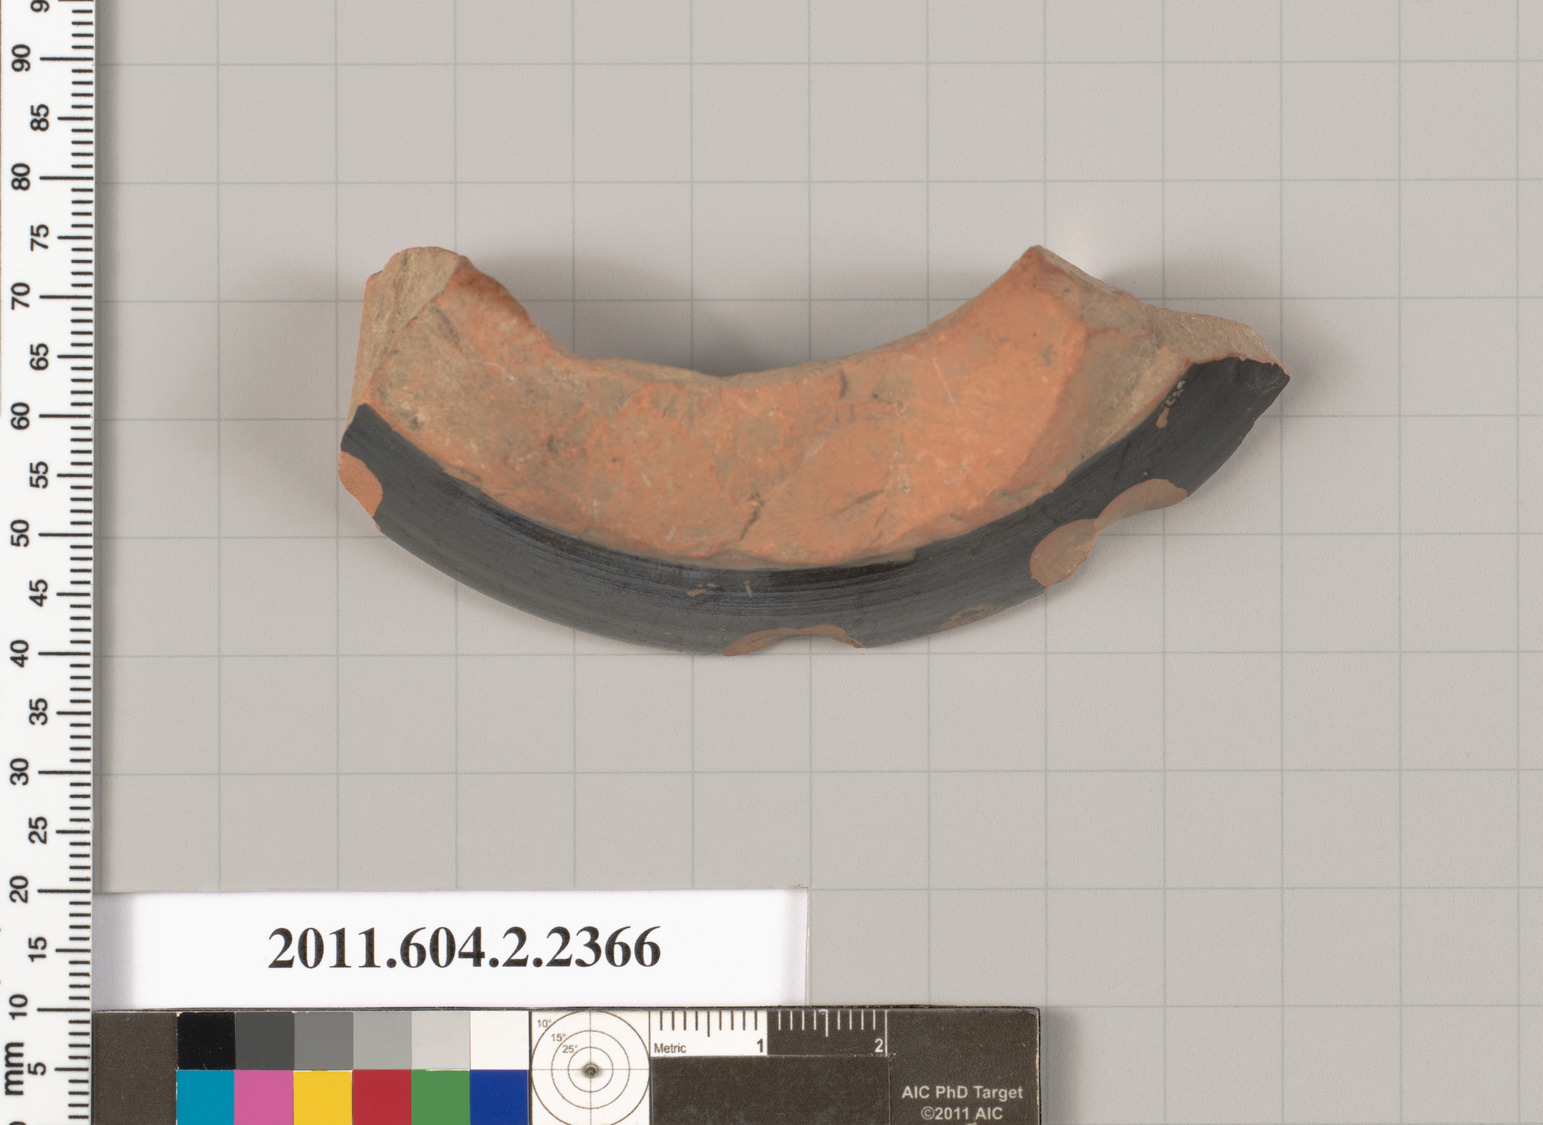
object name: psykter fragment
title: Terracotta fragment of a psykter (vase for cooling wine)?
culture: greek, attic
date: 490-470 BCE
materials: terracotta